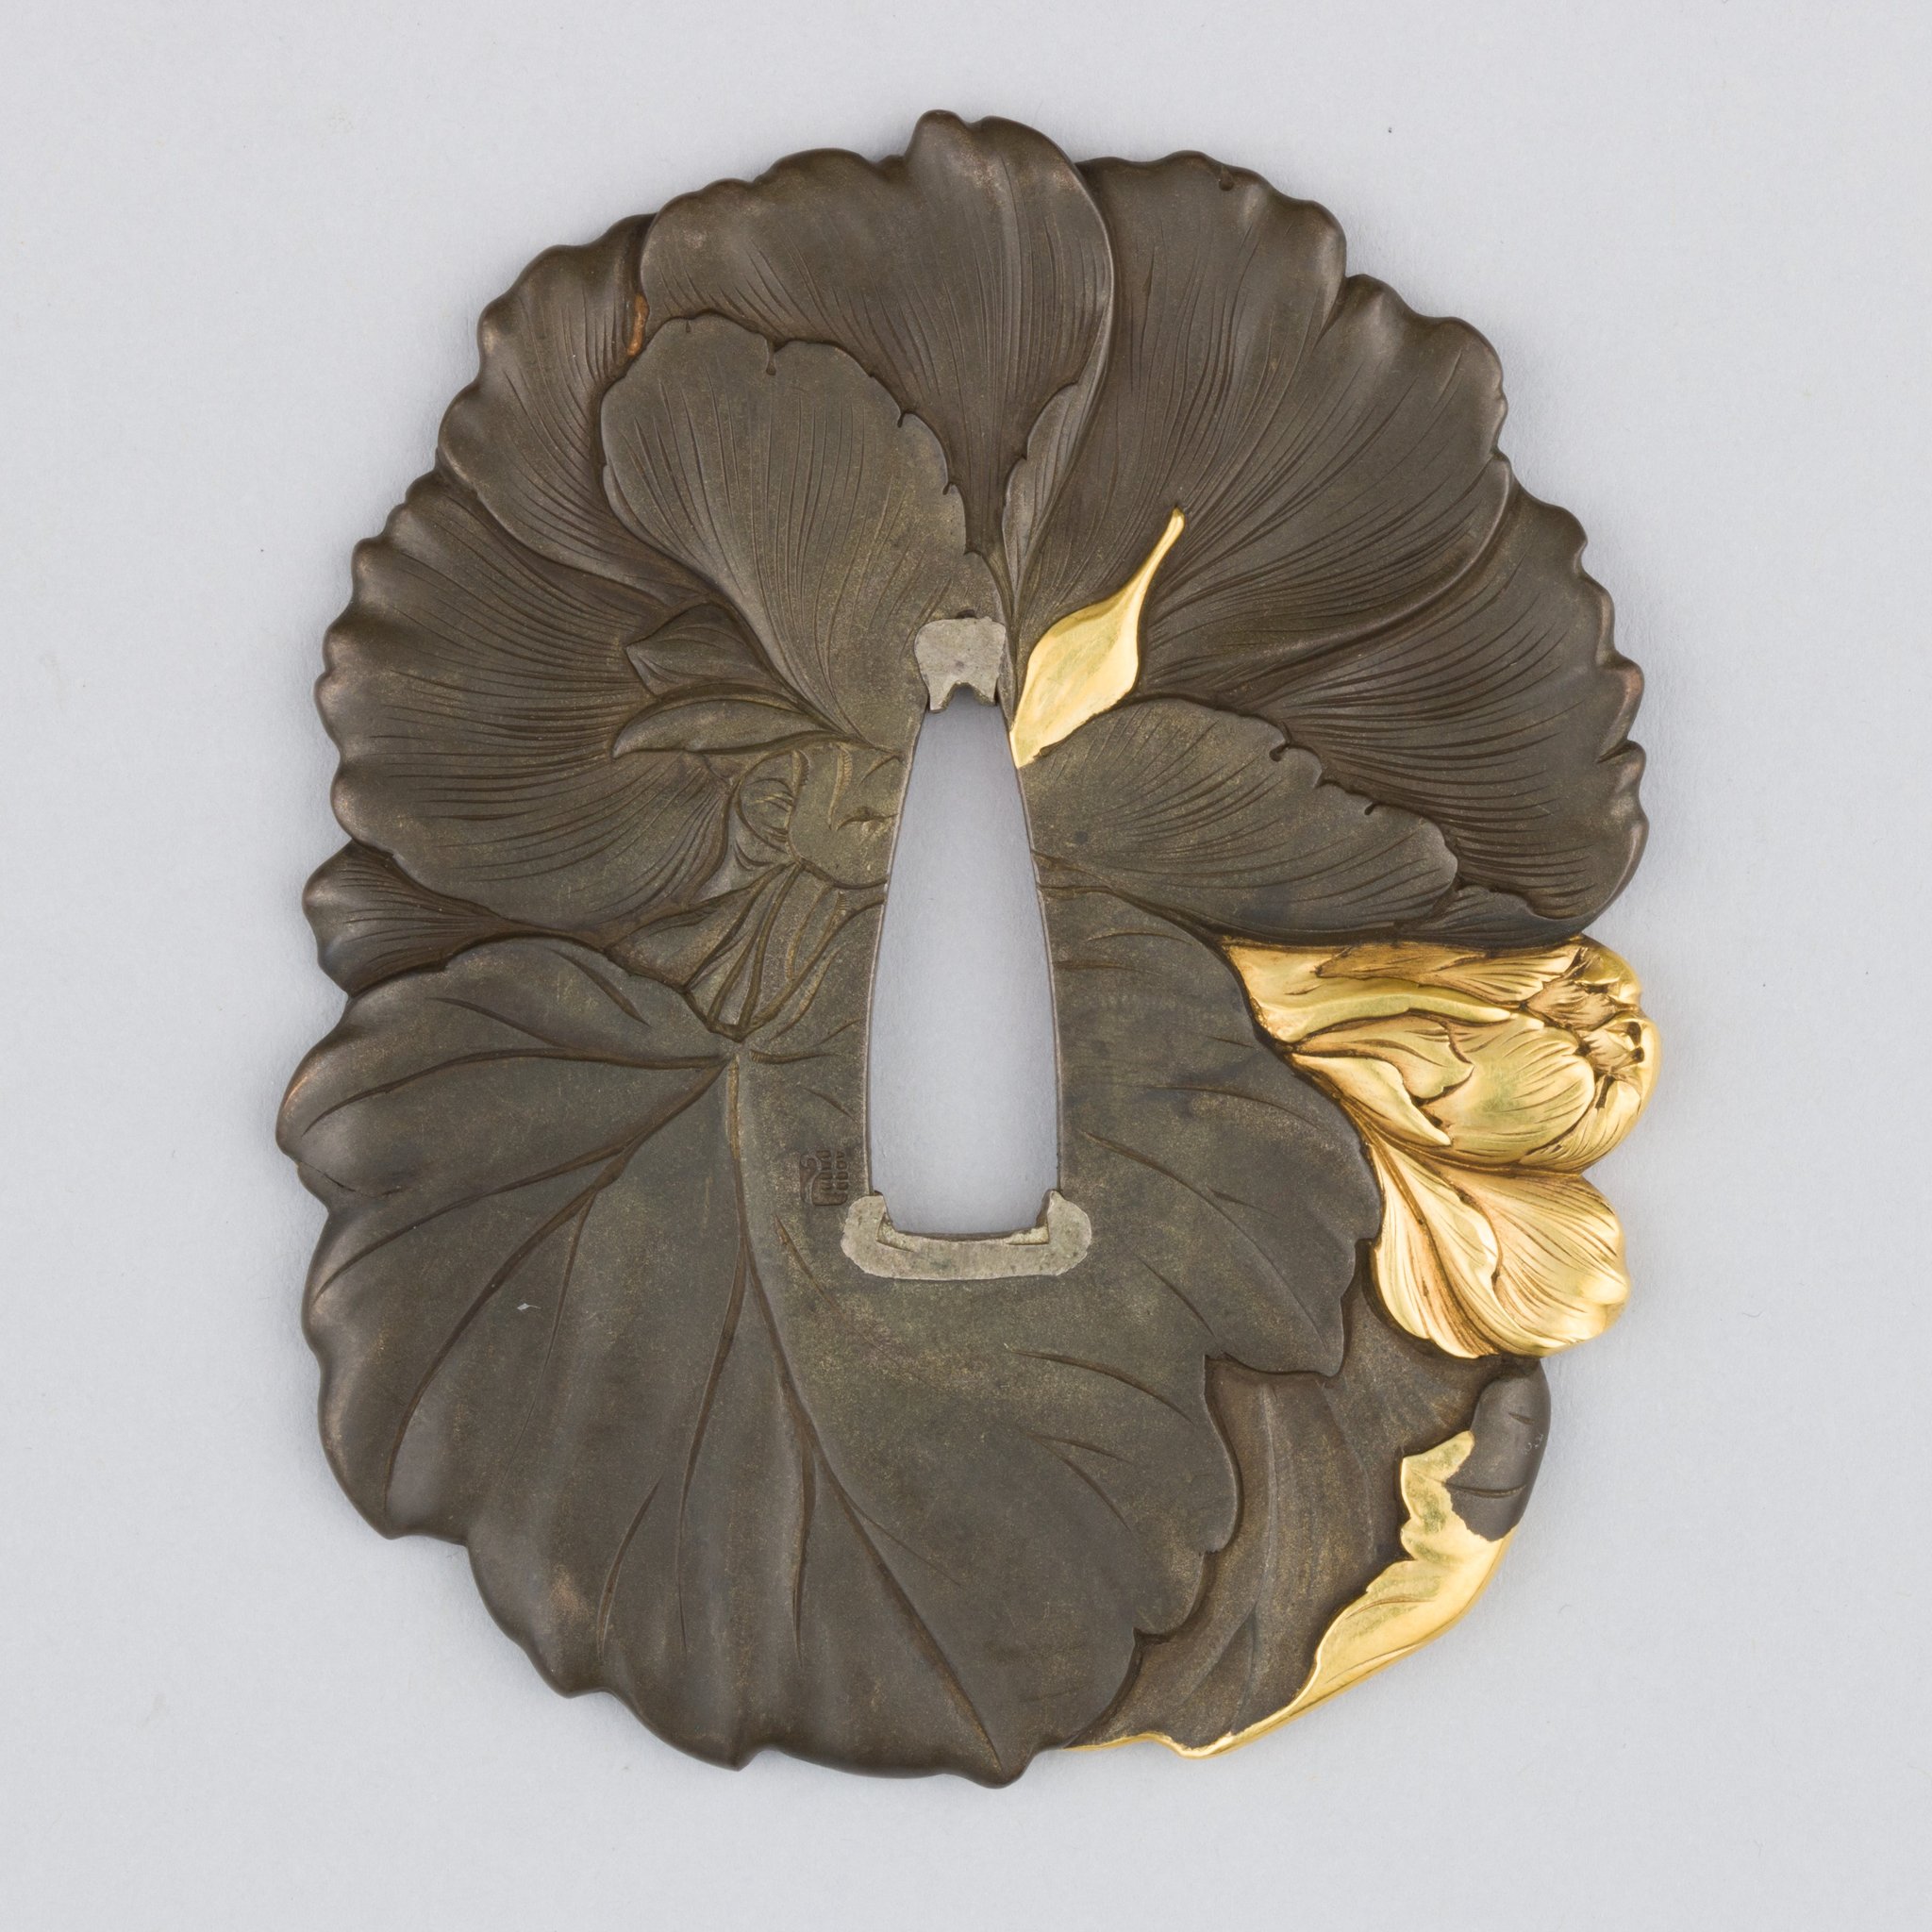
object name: sword guard tsuba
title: Sword Guard (Tsuba)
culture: japanese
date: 1615-1868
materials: copper, silver alloy, gold, silver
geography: japan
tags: flowers